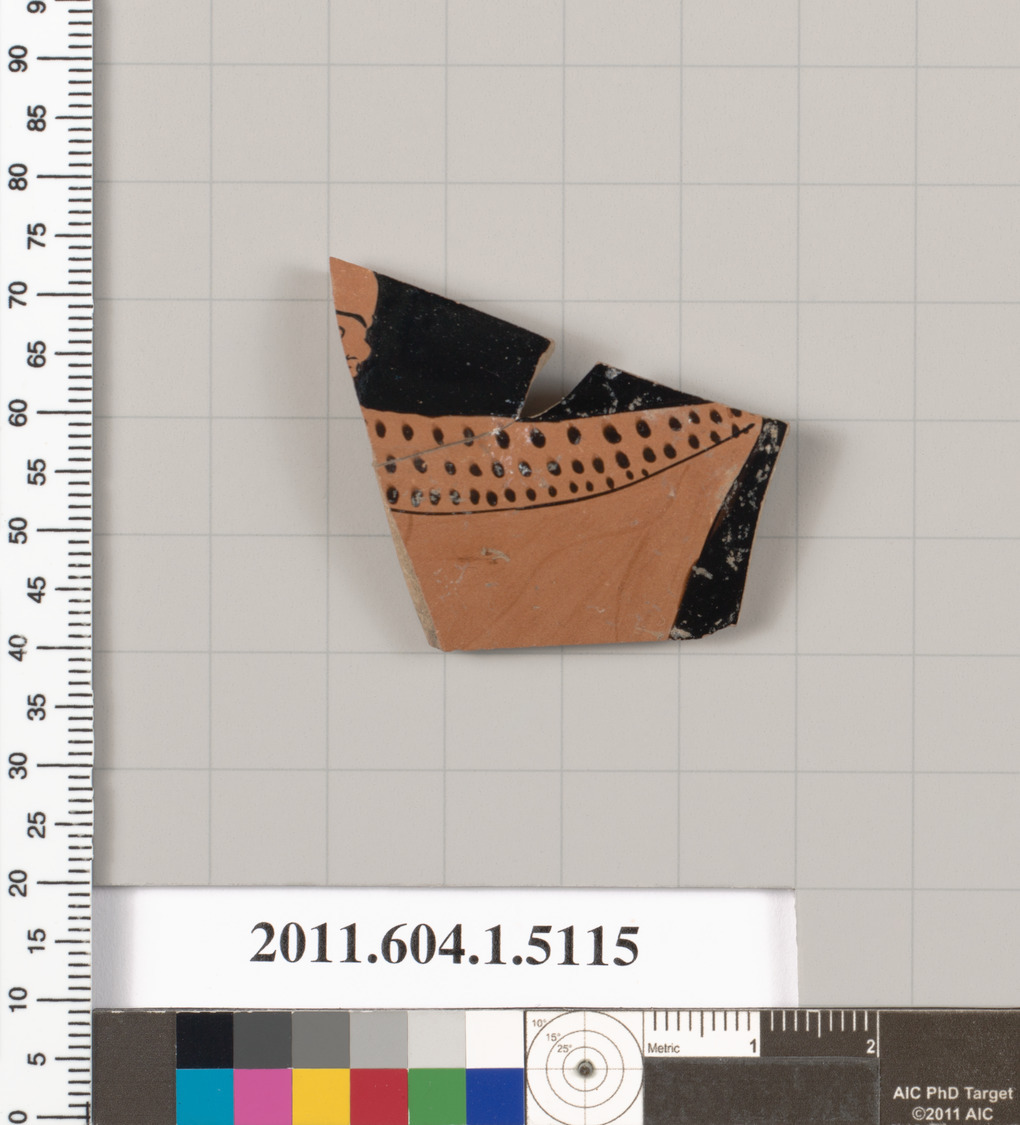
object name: kylix fragment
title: Terracotta fragment of a kylix (drinking cup)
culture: greek, attic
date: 490-470 BCE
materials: terracotta